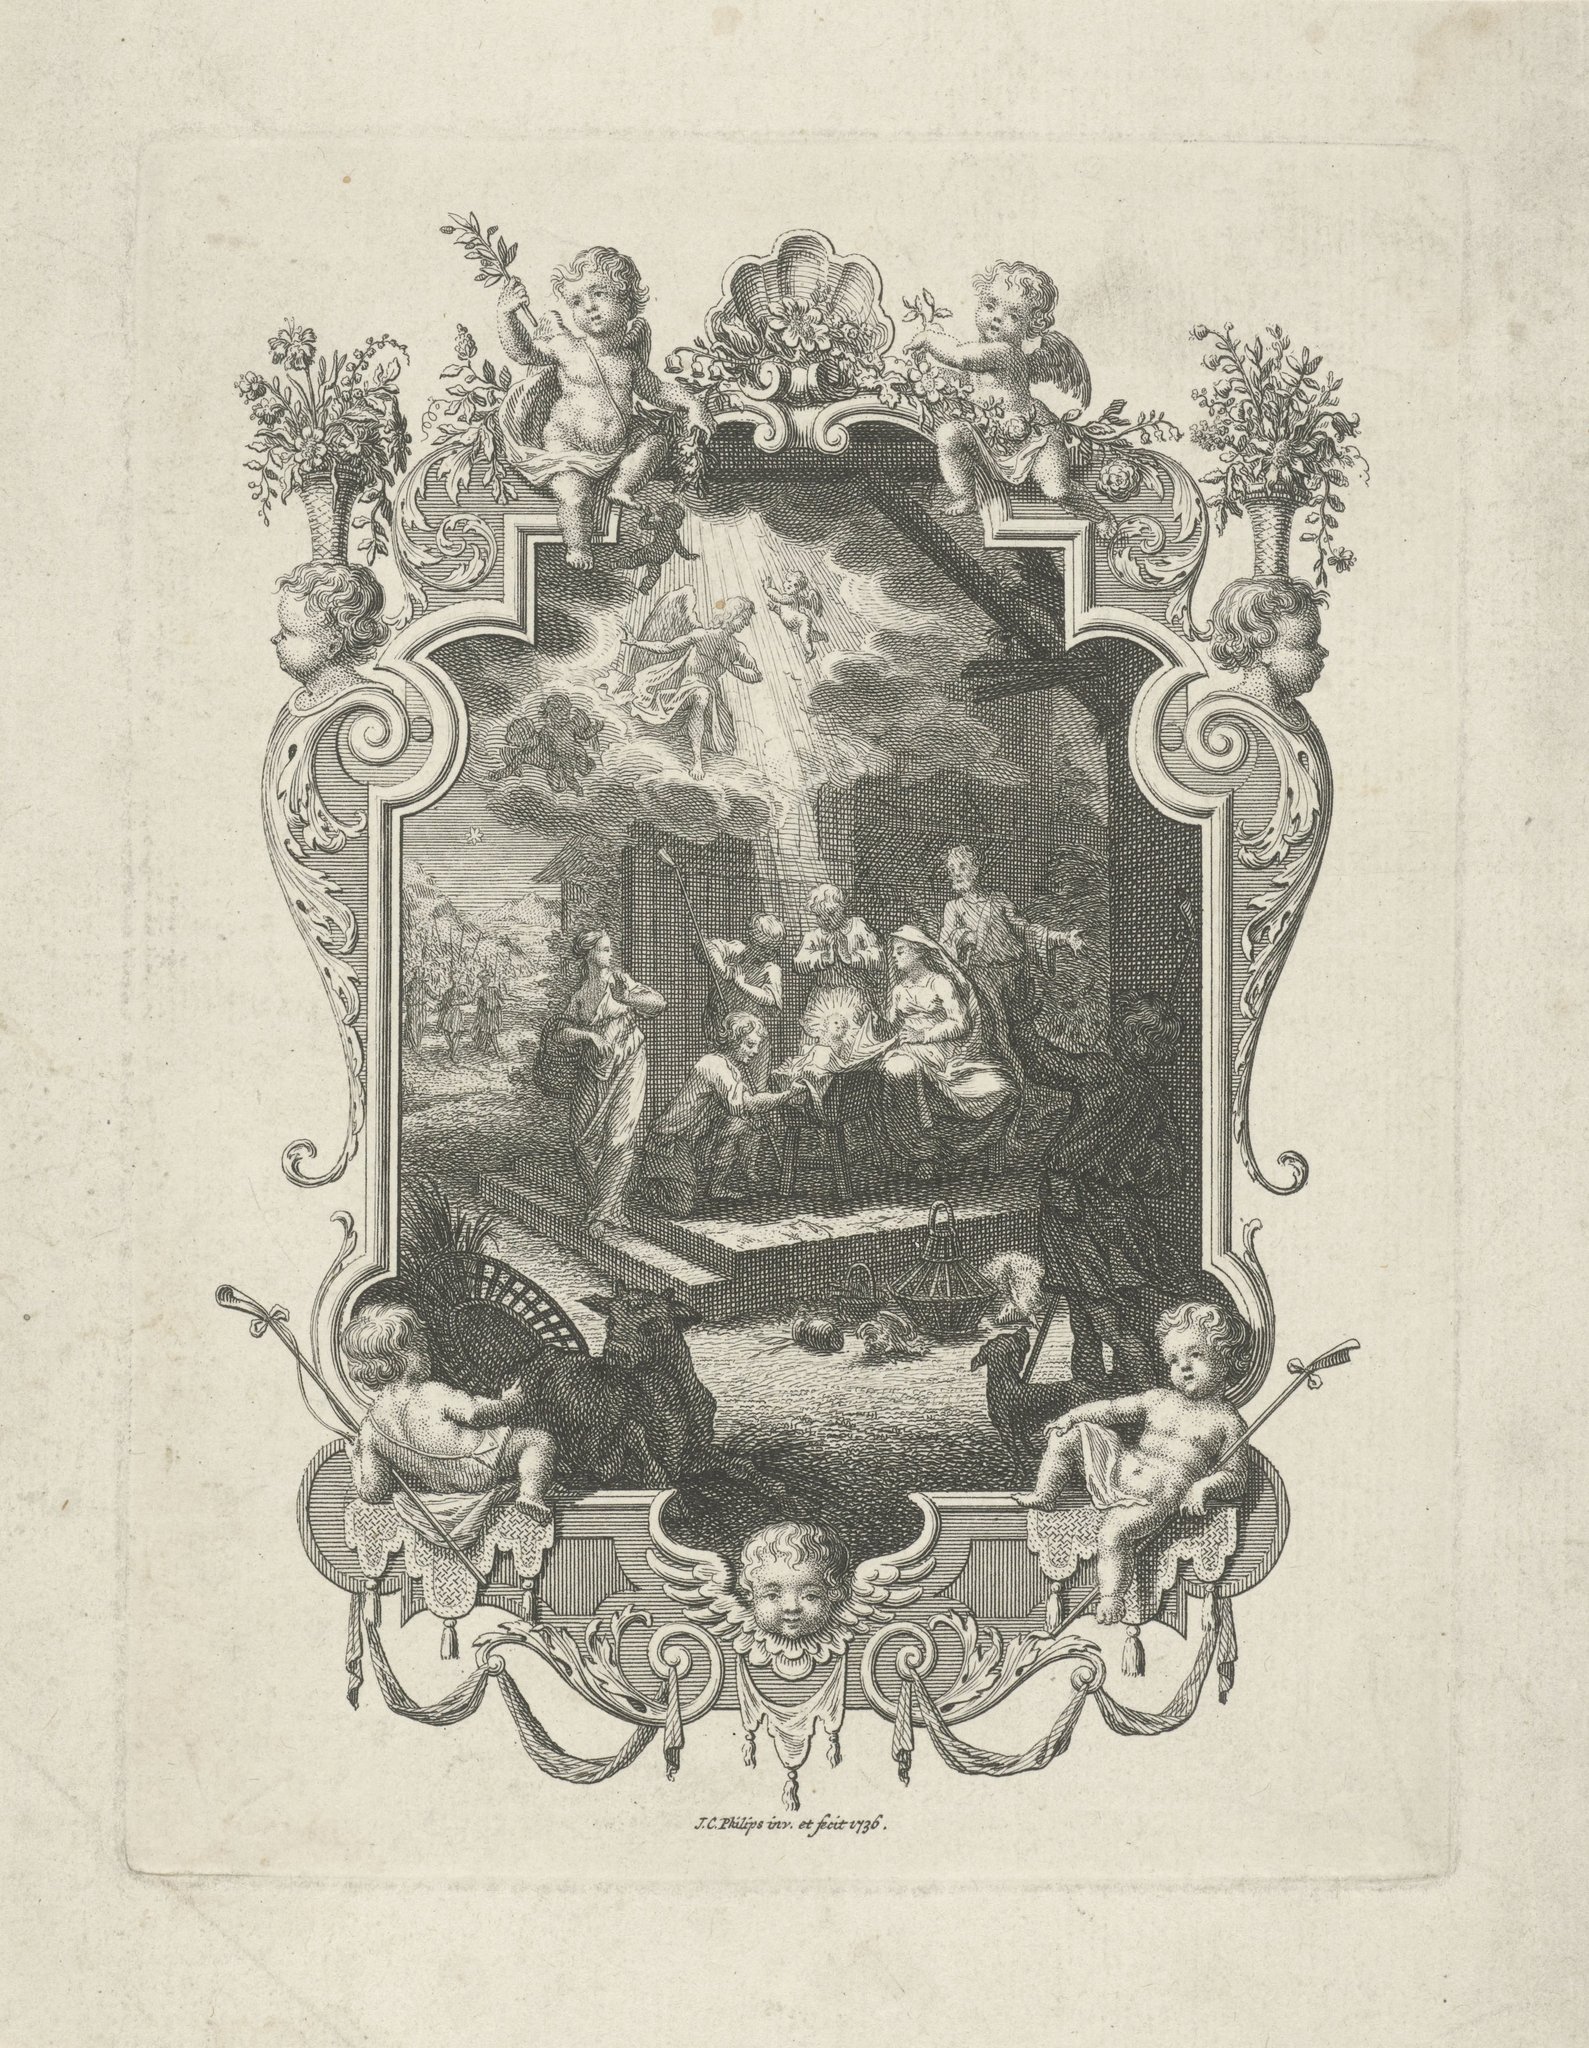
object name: print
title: Cartouche met de aanbidding door de herders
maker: jan caspar philips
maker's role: draughtsman, print maker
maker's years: 1700-1775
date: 1736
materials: paper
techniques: engraving, etching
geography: amsterdam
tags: adoration of the christ-child by the shepherds; mary and joseph present, the star appears again and guides the three wise men to bethlehem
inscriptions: collector's mark: Lugt 2228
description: De geboorte van Christus in de stal. Stralen uit de hemel beschijnen het kind. De herders knielen in aanbidding. Links op de achtergrond de koningen op weg naar Bethlehem.